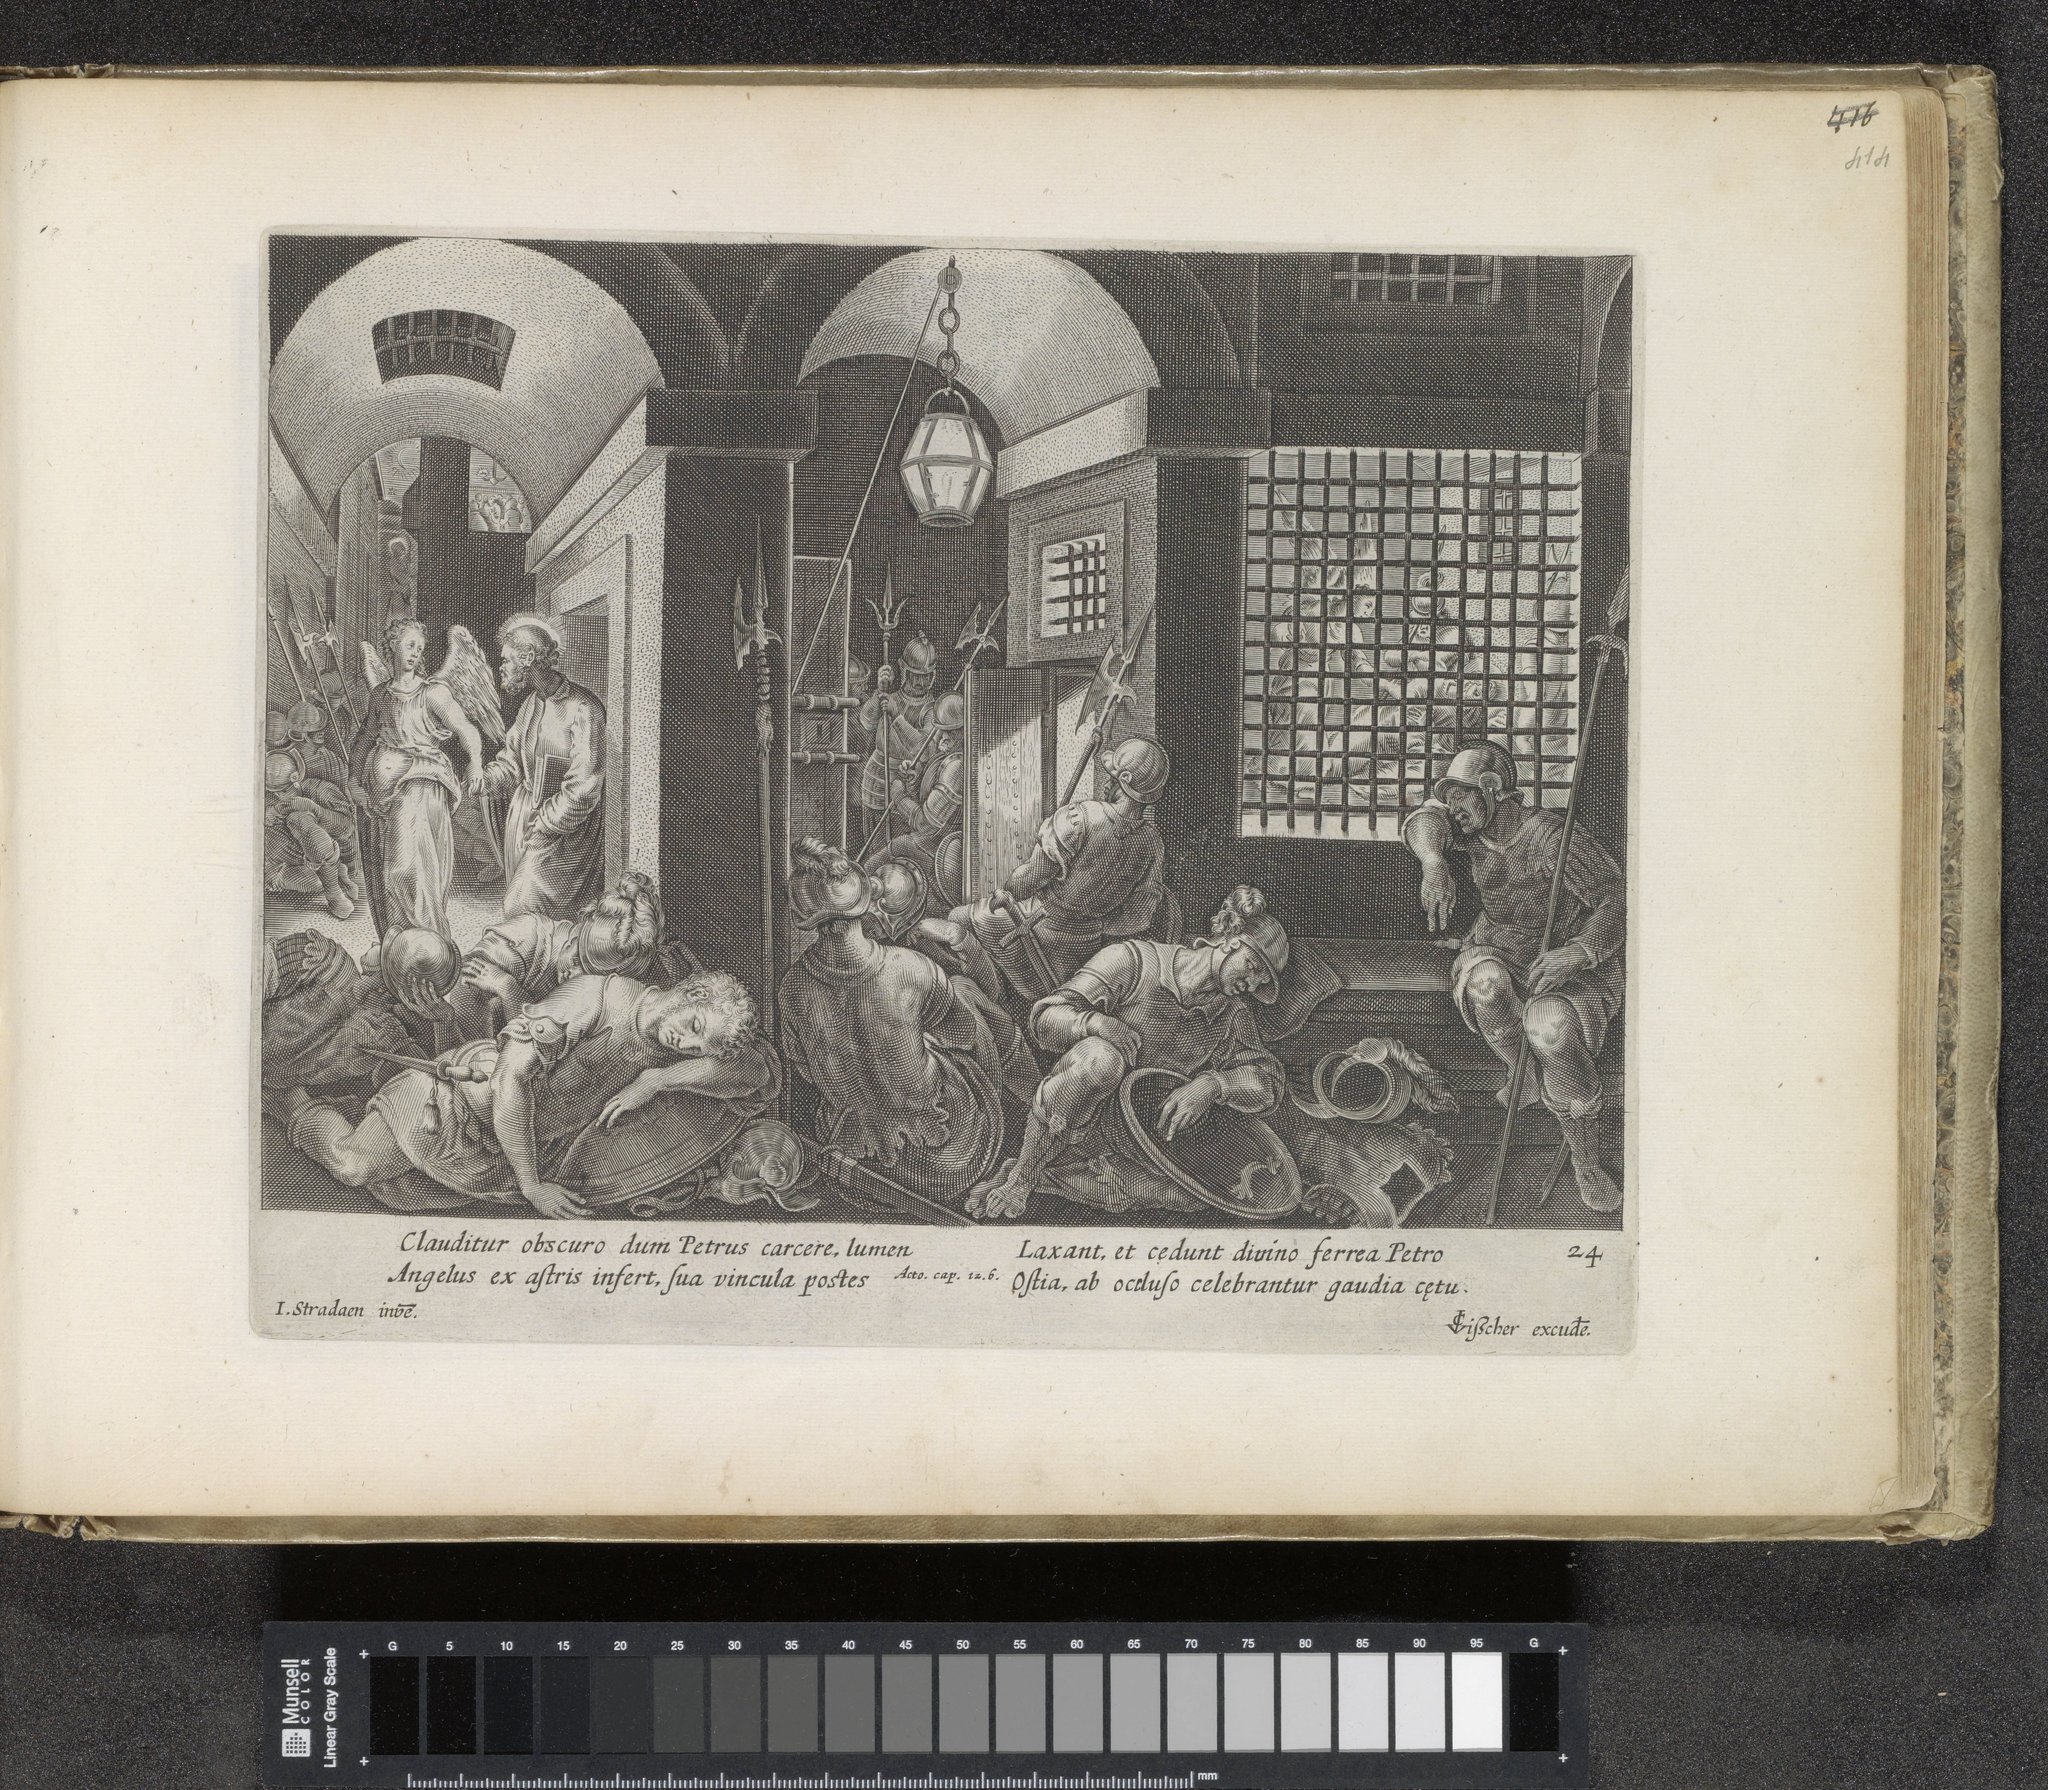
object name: print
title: Handelingen van de apostelen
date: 1643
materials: paper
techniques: engraving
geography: amsterdam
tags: an angel appears, summoning peter to wake up ~ peter in prison, the angel leads peter past the sleeping guards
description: Petrus wordt in de gevangenis gewekt door een engel (rechts). De engel bevrijdt hem en leidt hem (links) uit de gevangenis, langs de slapende soldaten. Onder de voorstelling een verwijzing in het Latijn naar de Bijbeltekst in Hand. 12:6. Deze prent maakt deel uit van een album.